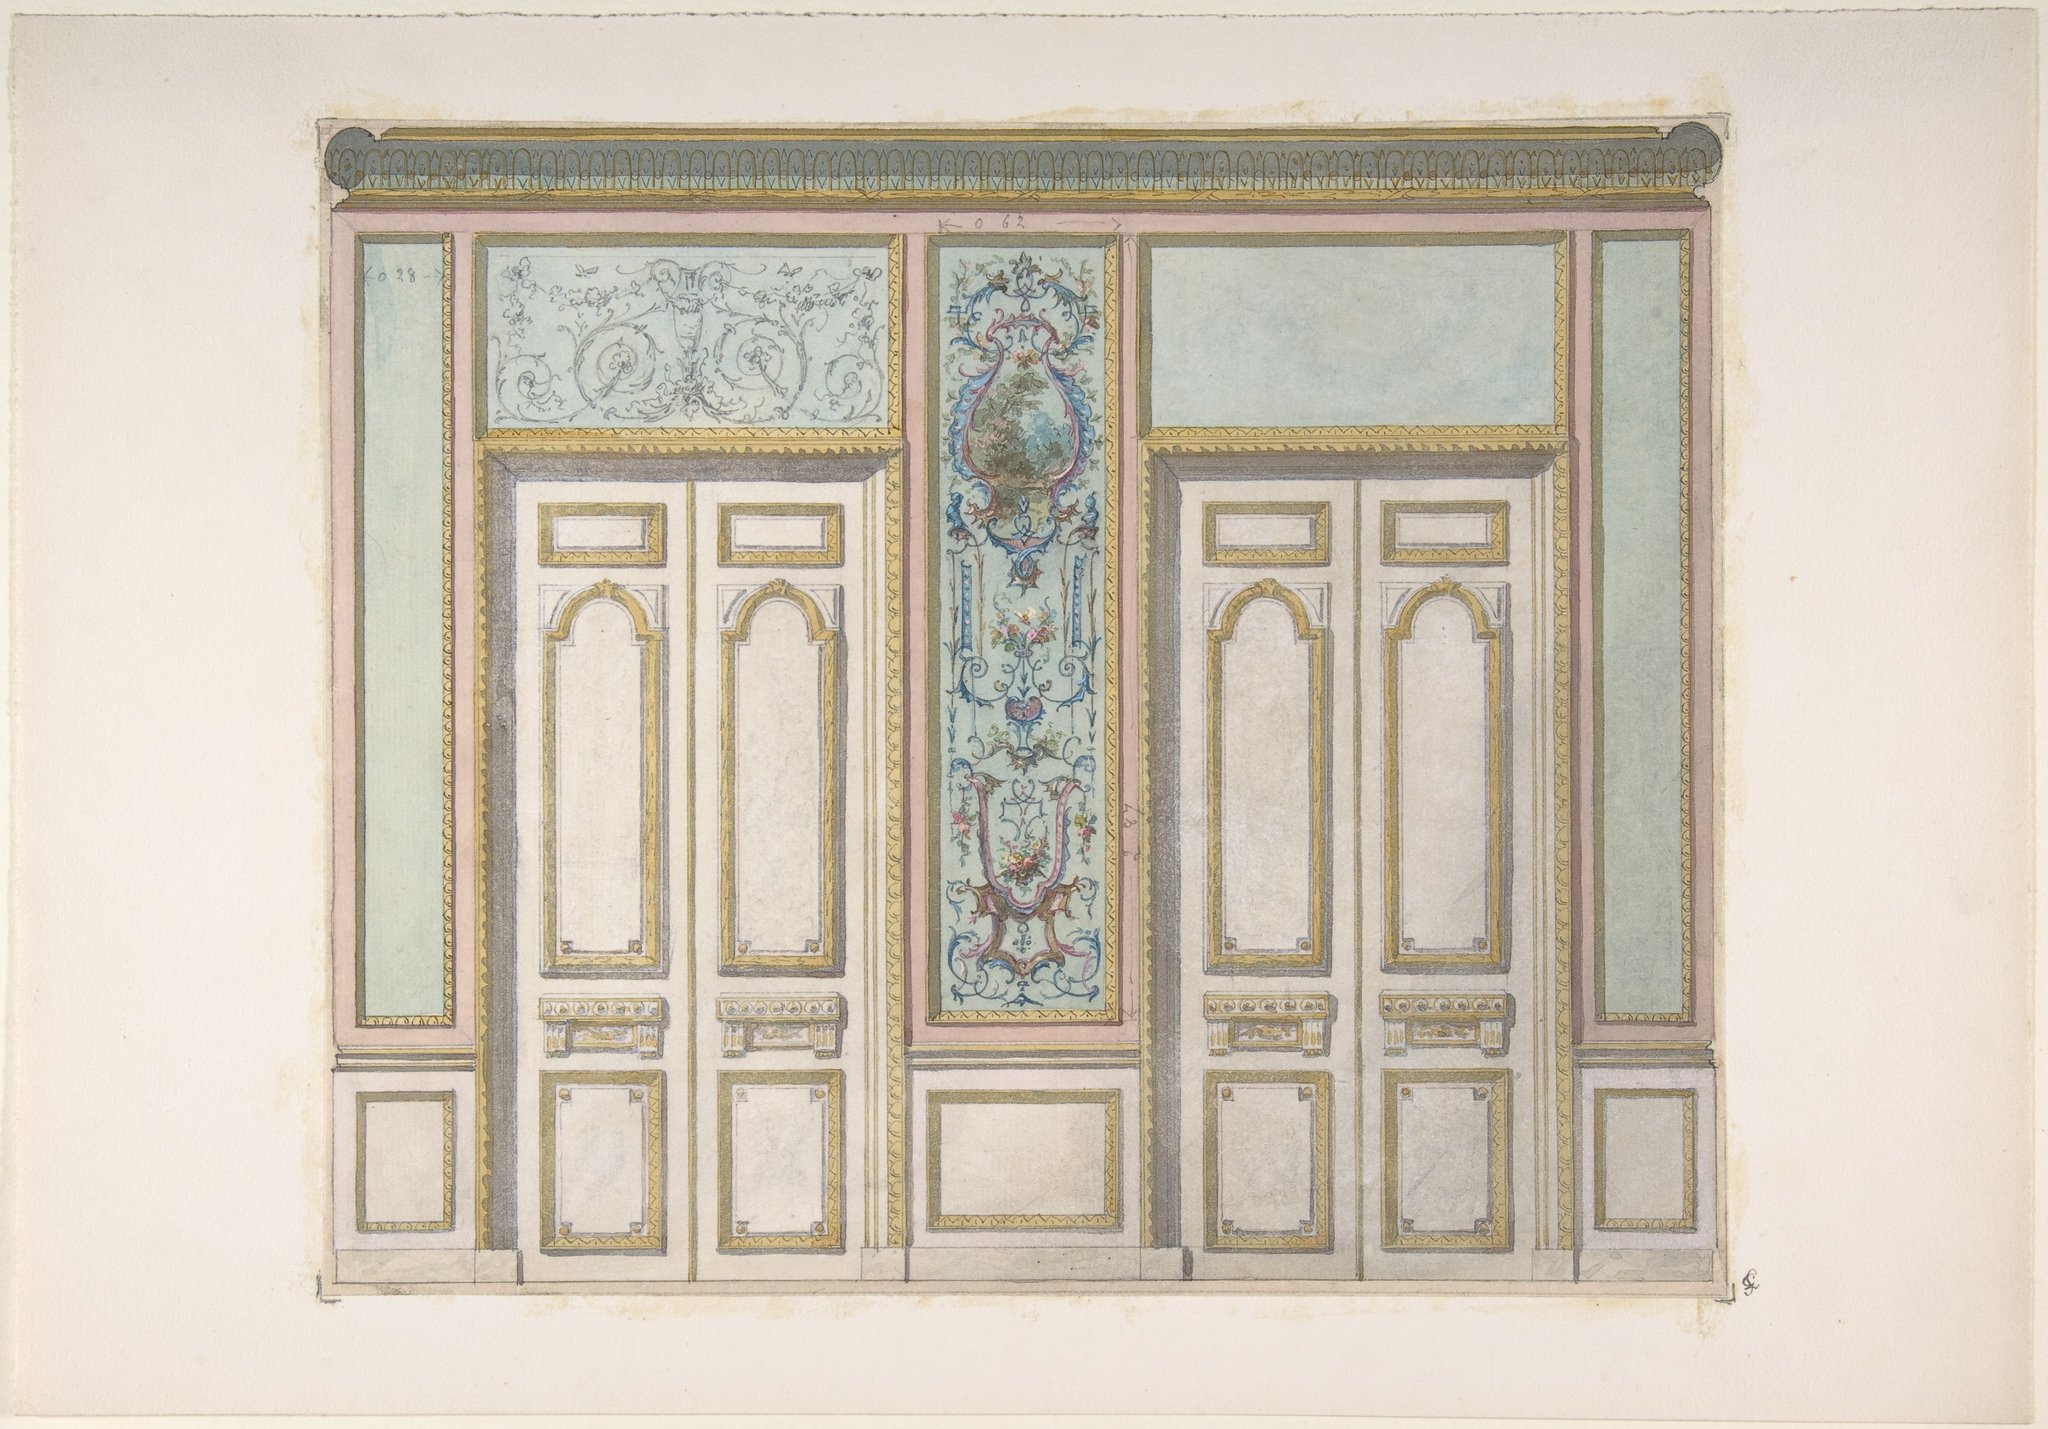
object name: drawing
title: Design for a Pair of Doors Joined by an Ornamental Panel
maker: jules-edmond-charles lachaise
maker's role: artist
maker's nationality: french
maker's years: 1897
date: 1851-1900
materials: graphite, ink, watercolor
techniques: pen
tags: doors,ornament